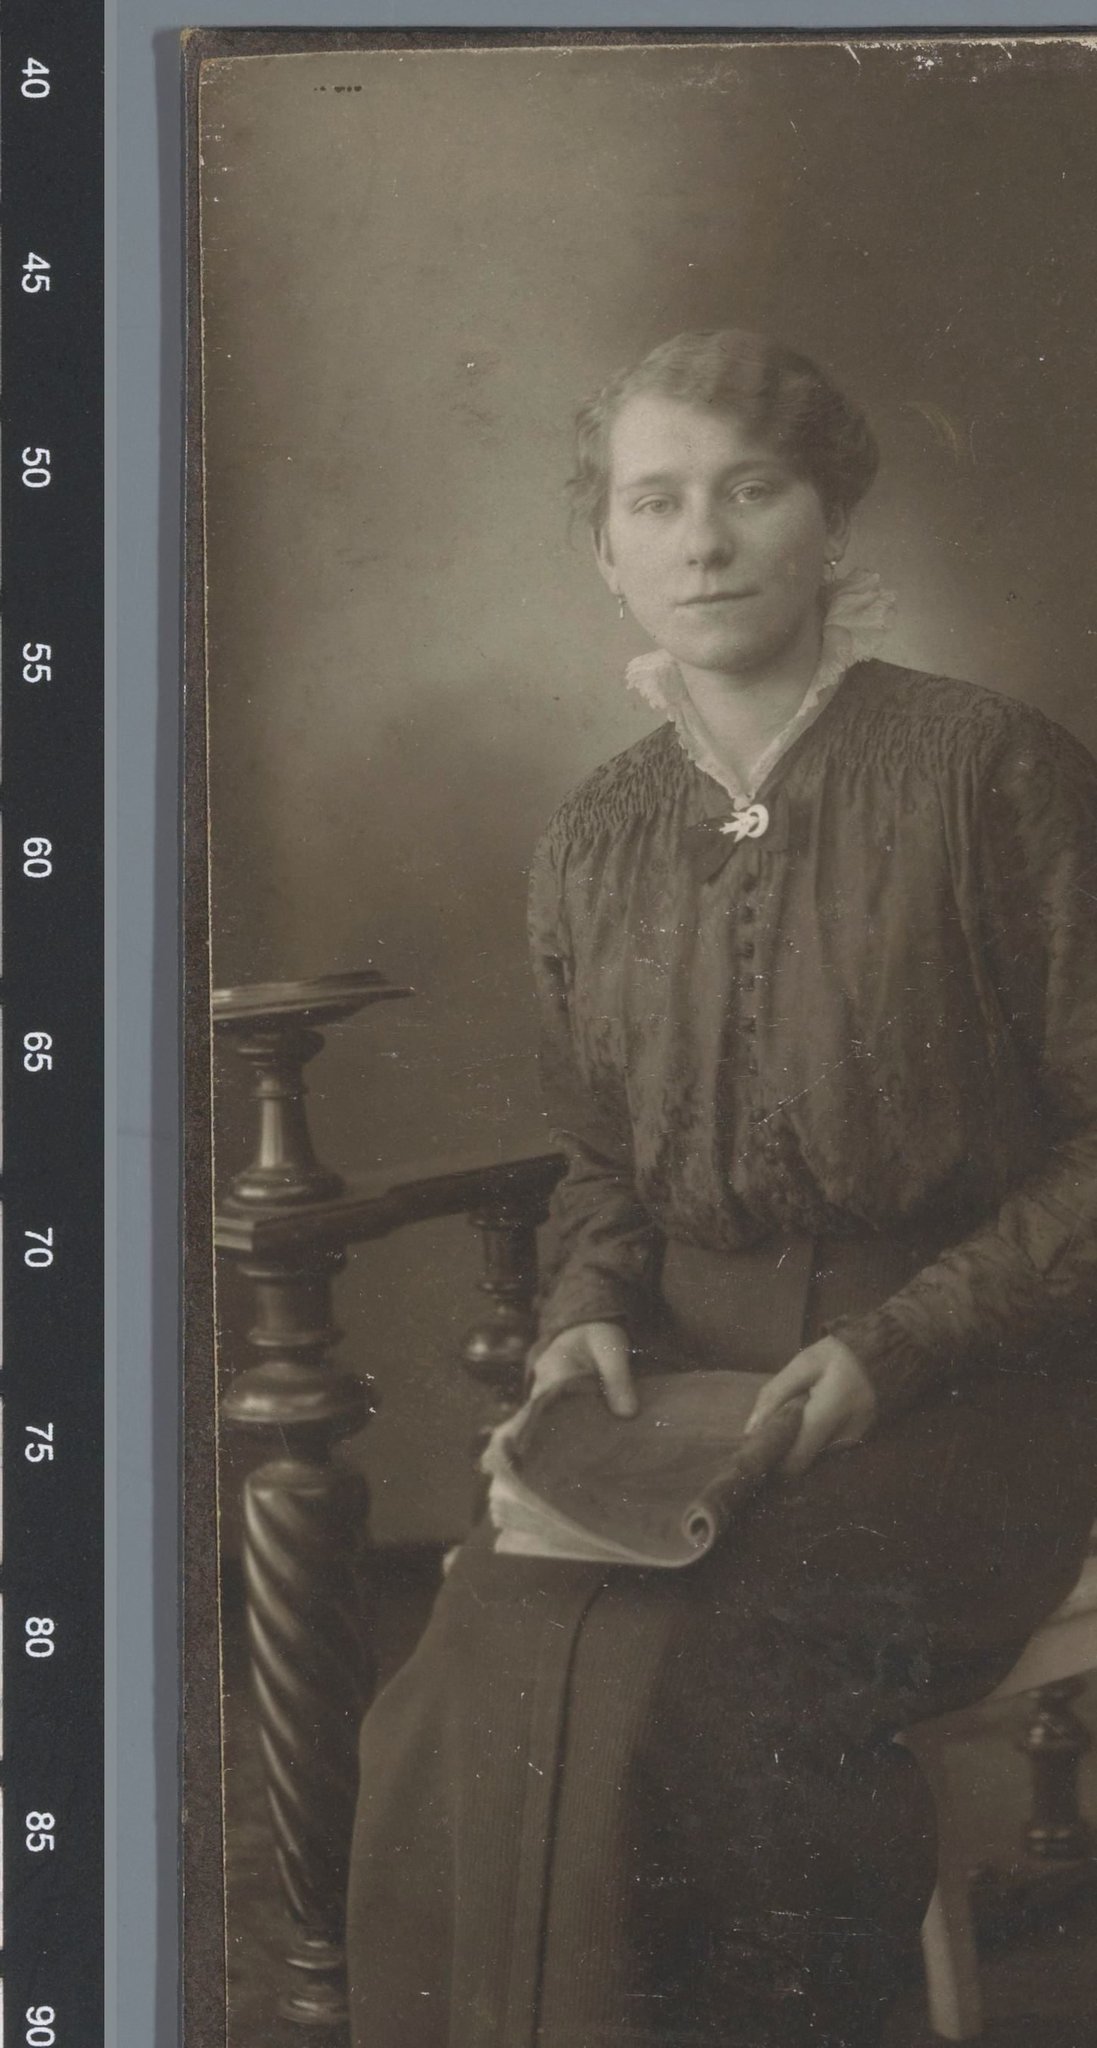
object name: photograph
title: Portret van een onbekende vrouw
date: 1900-1914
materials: paper, cardboard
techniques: gelatin silver print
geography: oberhausen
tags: adult woman, anonymous historical person portrayed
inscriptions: address: ‘ATELIER "CENTRAL"/ G. m. b. H./ OBERHAUSEN (Rhld)/ Marktstr. 68’, number: ‘10766’, inscription: ‘Vergrösserungen nach jedem (...)’